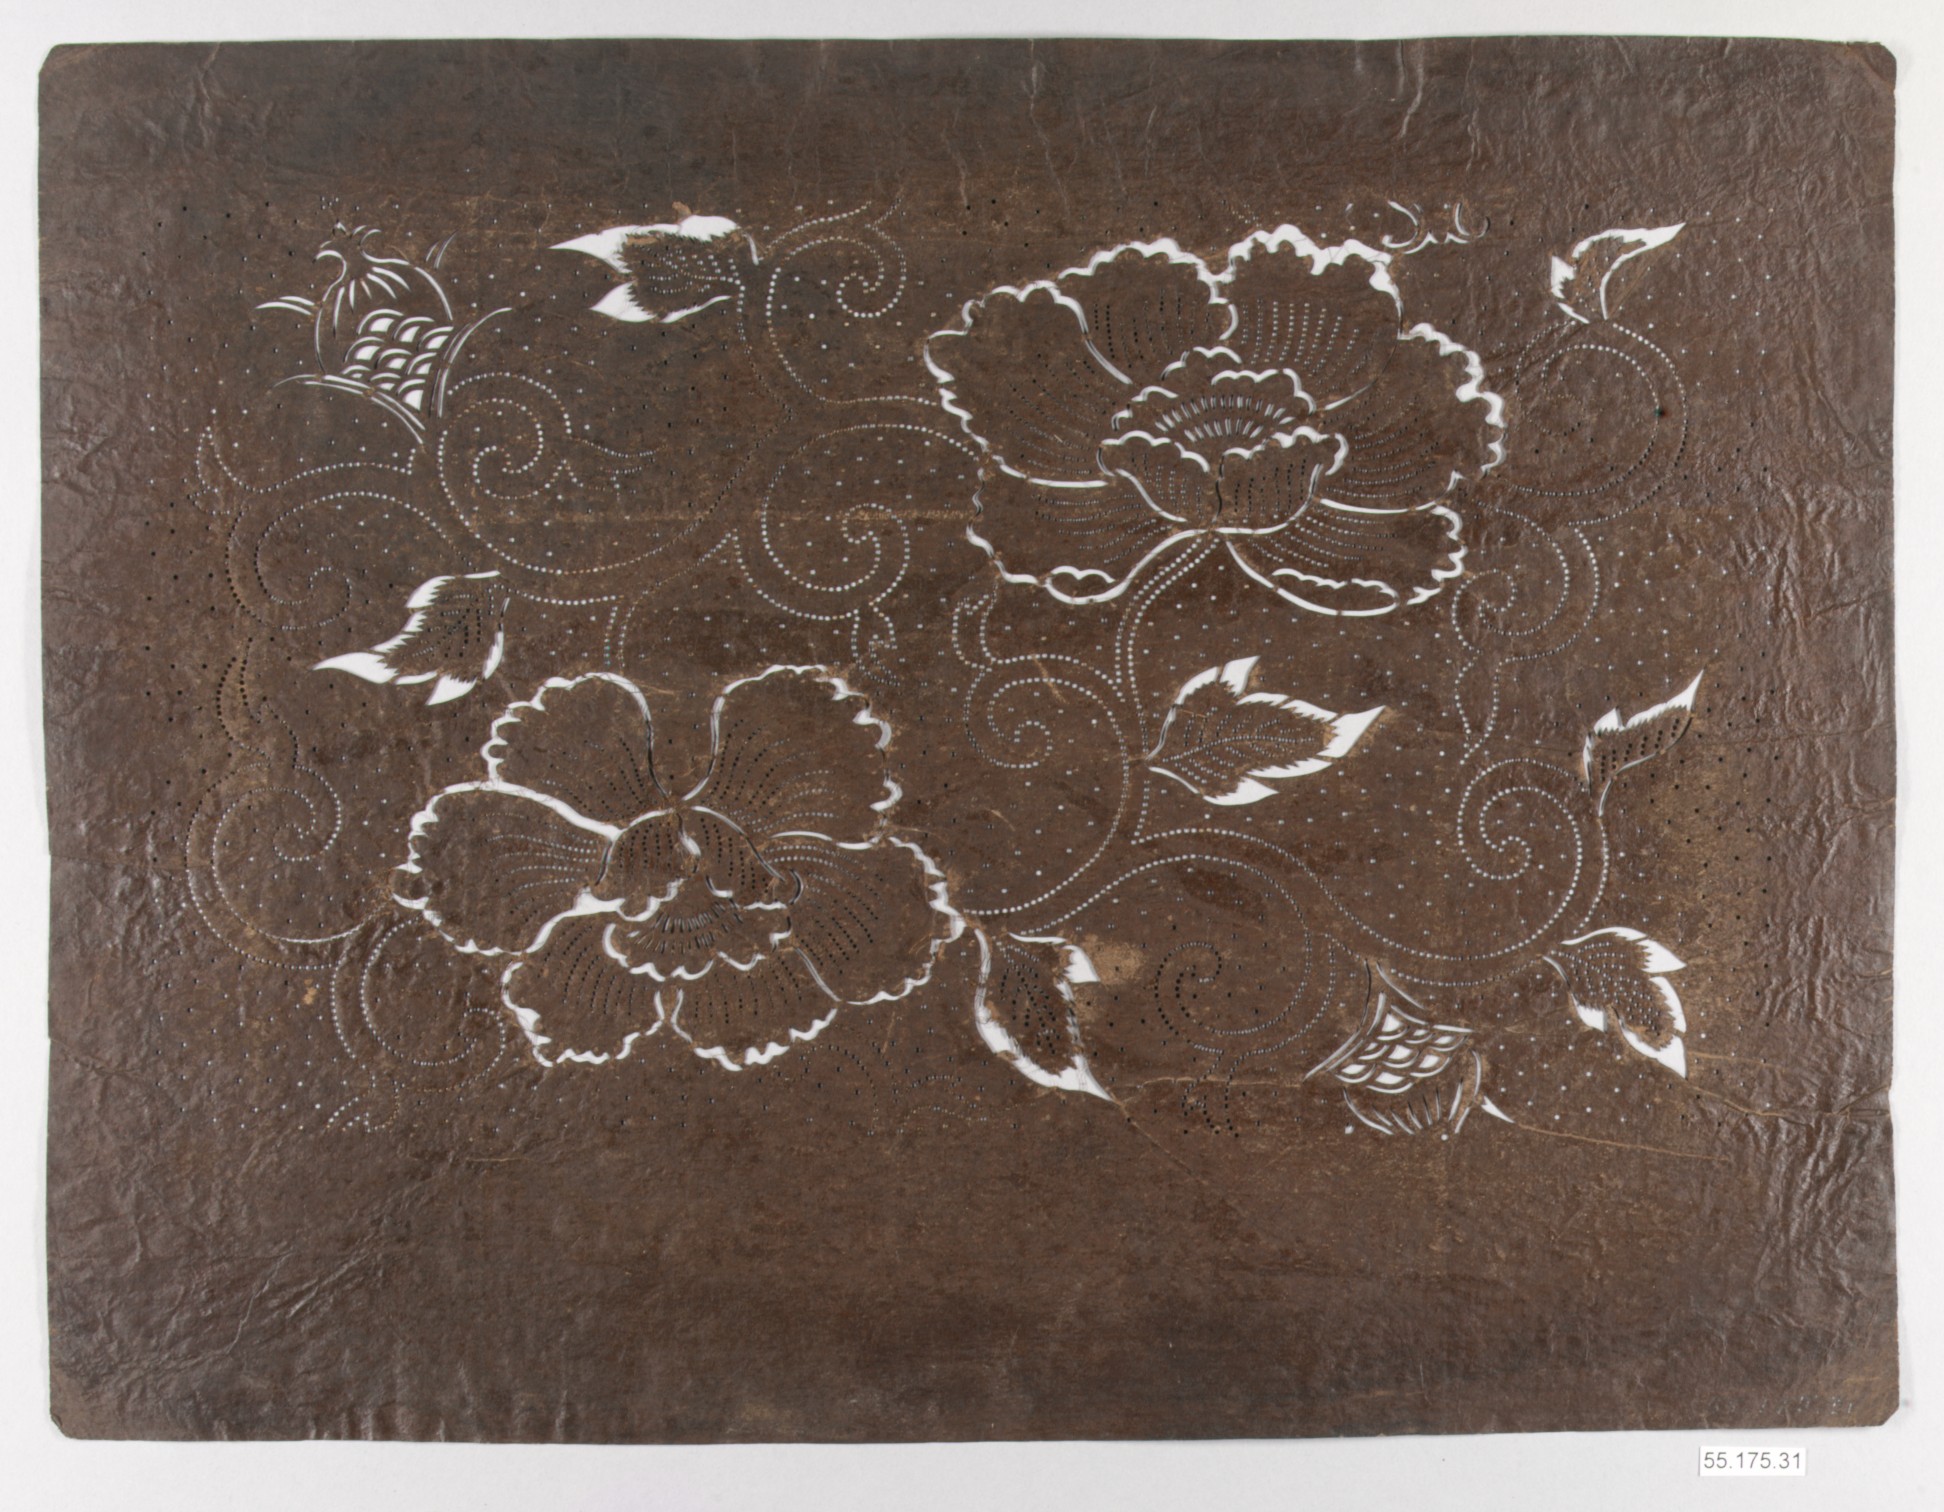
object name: stencil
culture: japanese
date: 1801-1900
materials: paper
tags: flowers